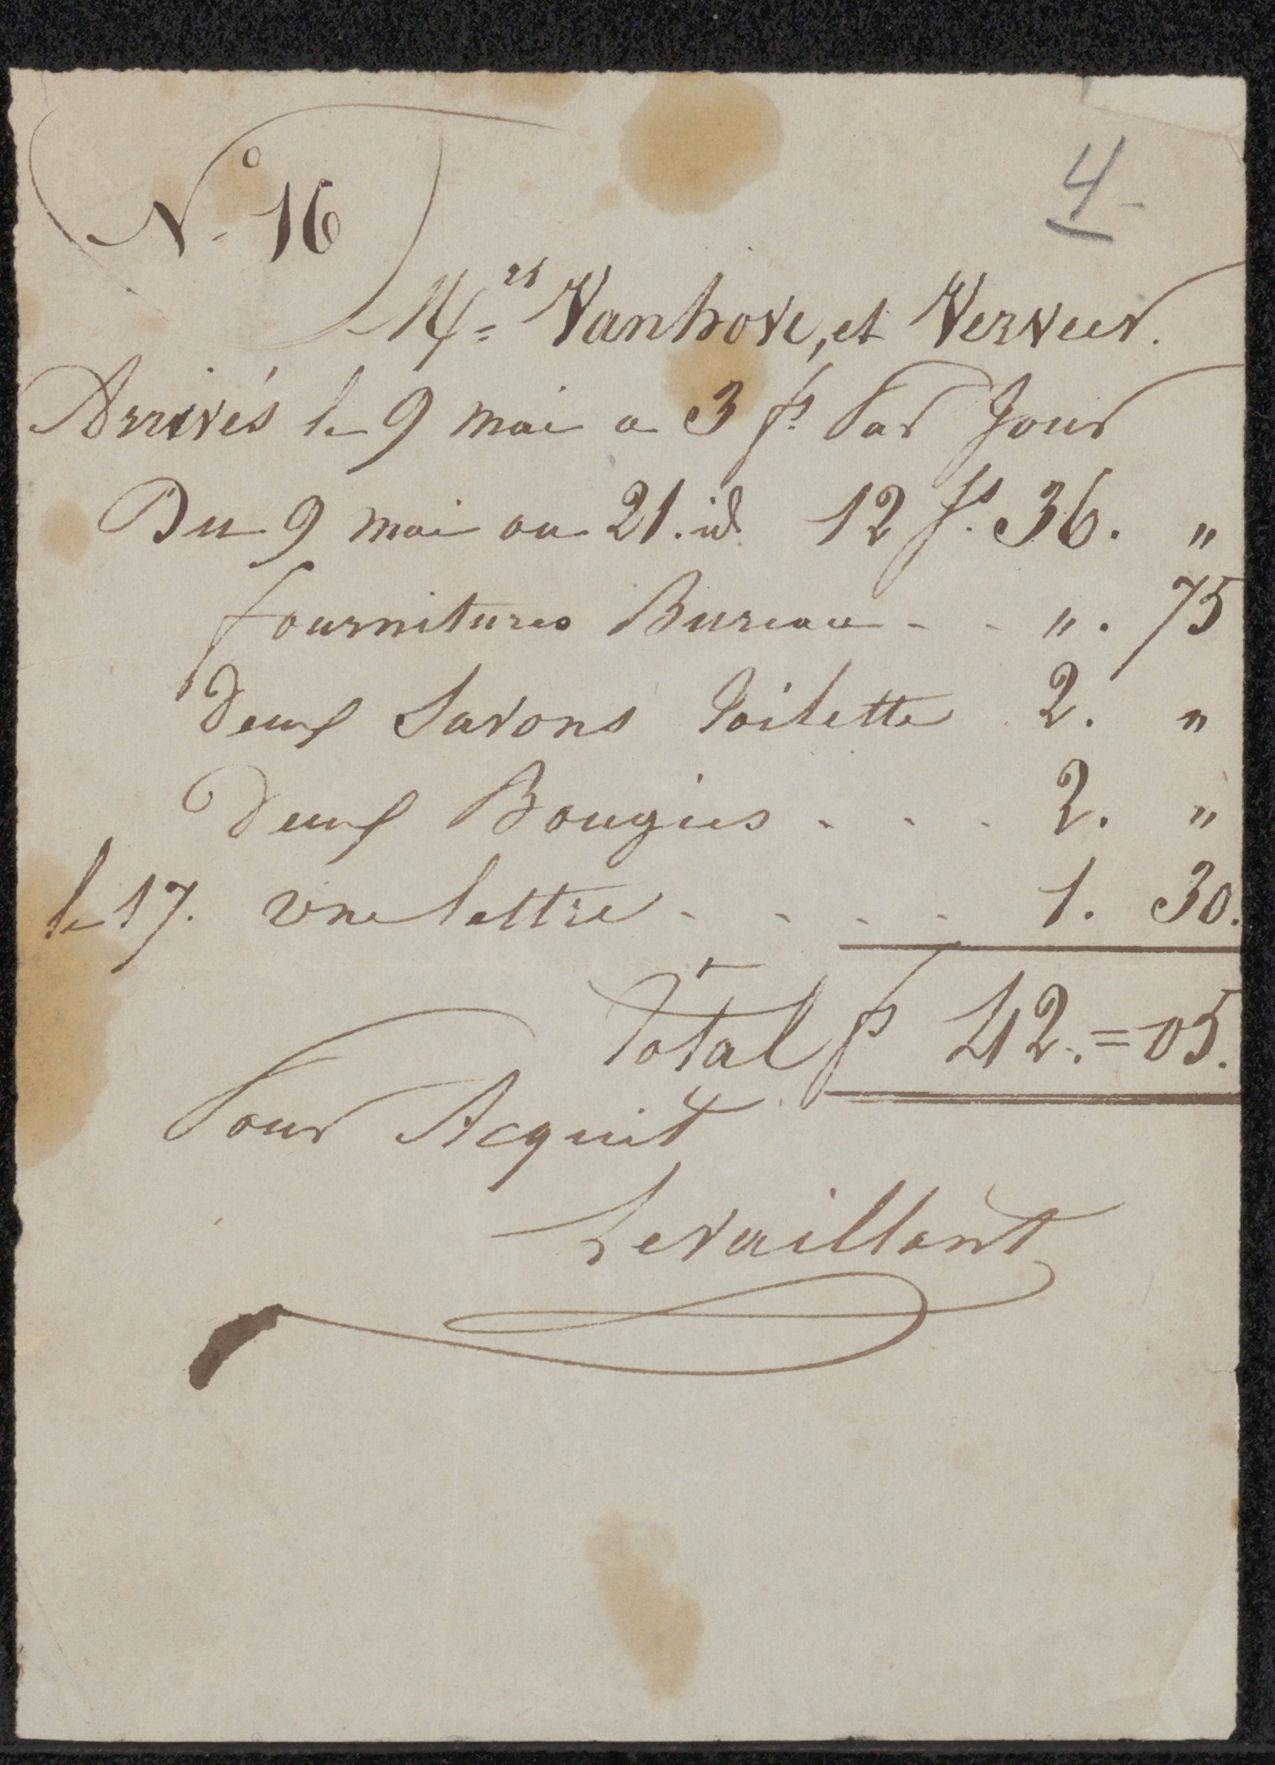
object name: account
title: Rekening voor Huib van Hove Bz en de heer Verveer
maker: Anonymous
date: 1824-1864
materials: ink, paper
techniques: pen, writing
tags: the hague, antwerp, painter, print maker, huib van hove bz, money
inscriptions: collector's mark: Lugt 2233